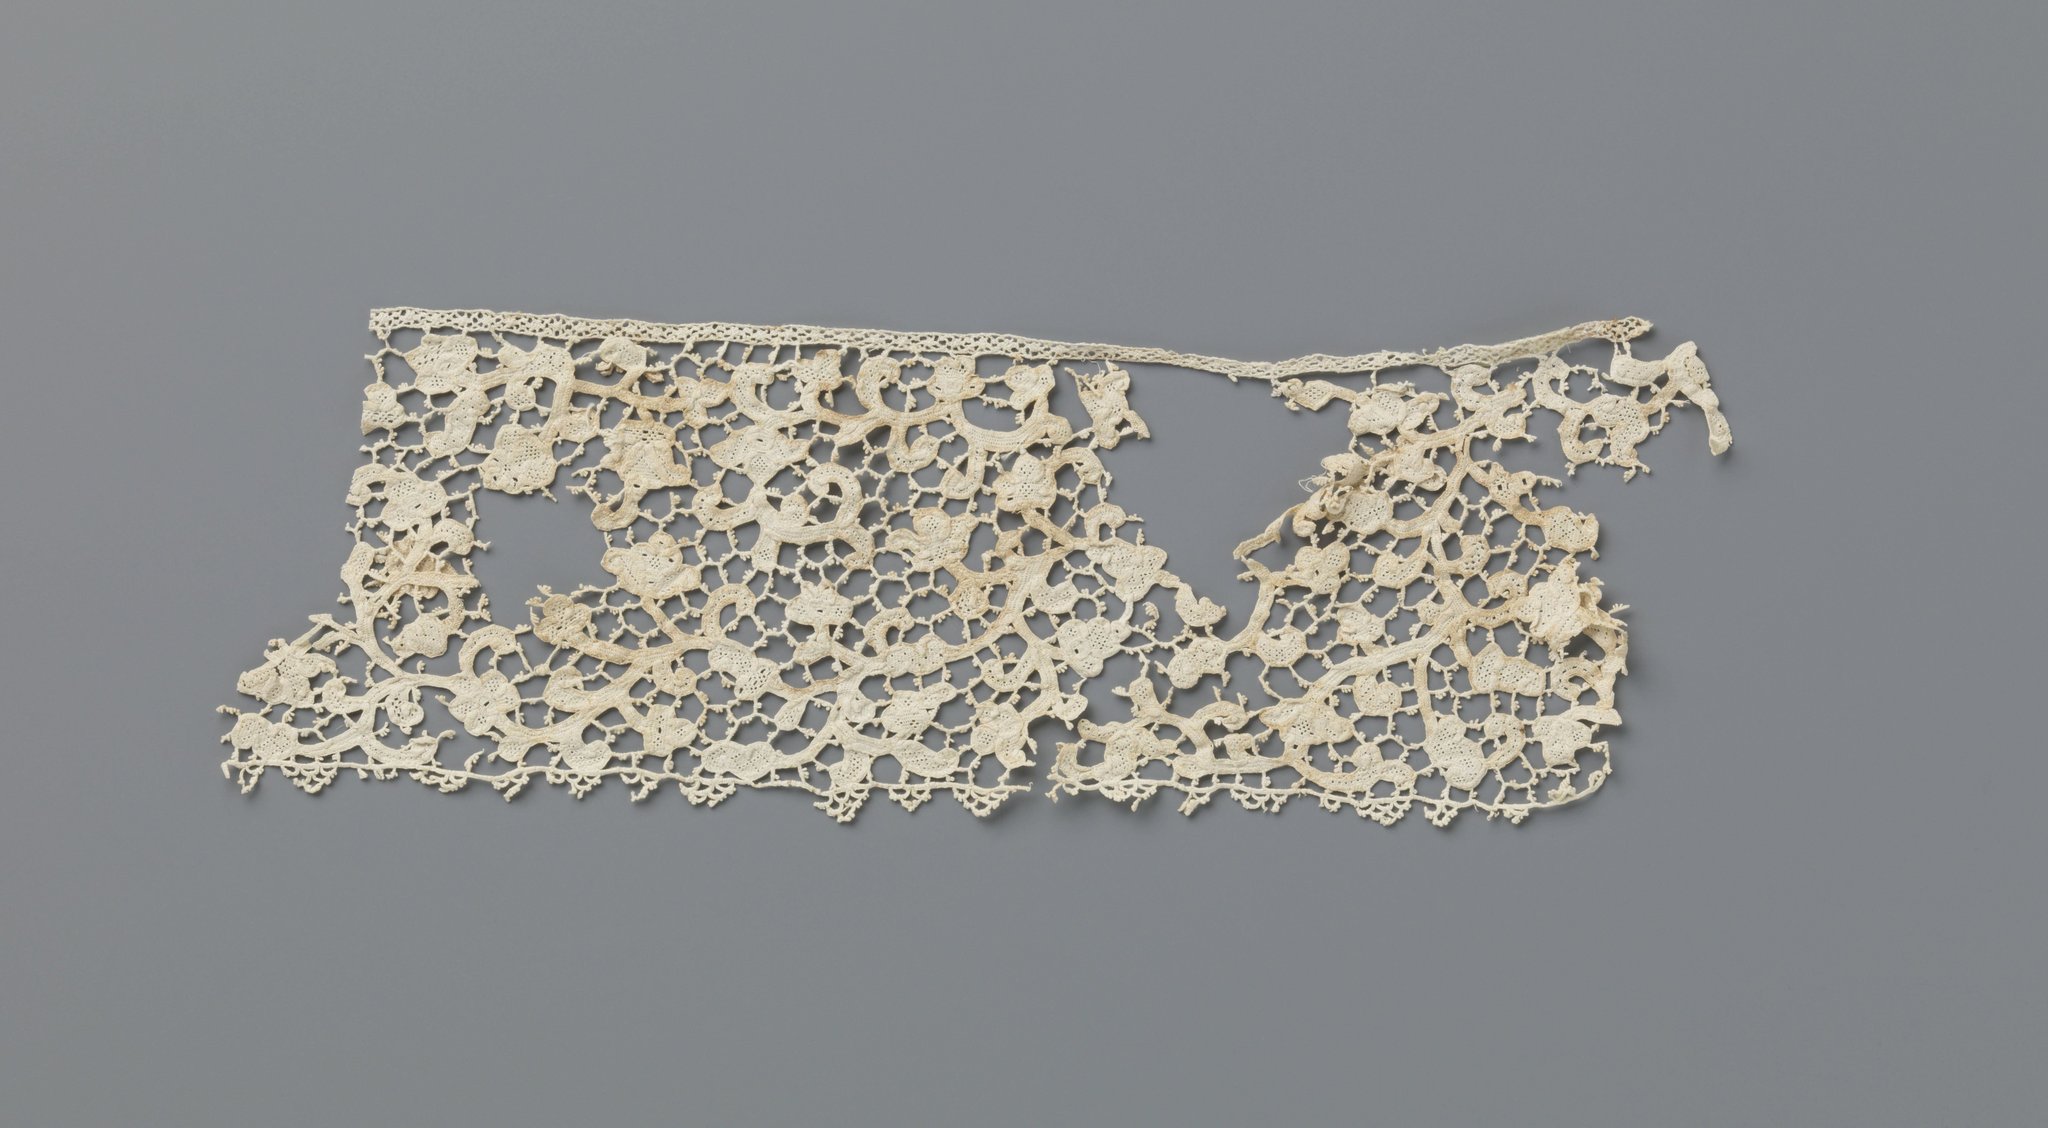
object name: strip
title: Strook naaldkant met krullende ranken en veelsoortige bloemen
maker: Anonymous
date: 1700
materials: linen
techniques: flat venetian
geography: venice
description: Strook naturelkleurig naaldkant, Venise plat. Patroon met rijk vertakte krullende ranken met kleine veelsoortige bloemen op een onregelmatige open grond met eenzijdig gepicoteerde spijlen. Volwerk met gedraaide festonsteken met daarin verschillende motieven doormiddel van uitsparingen. De bovenzijde is afgezet met een rand kloskant. De onderzijde is afgewerkt met een rechte picotrand met boogjes.